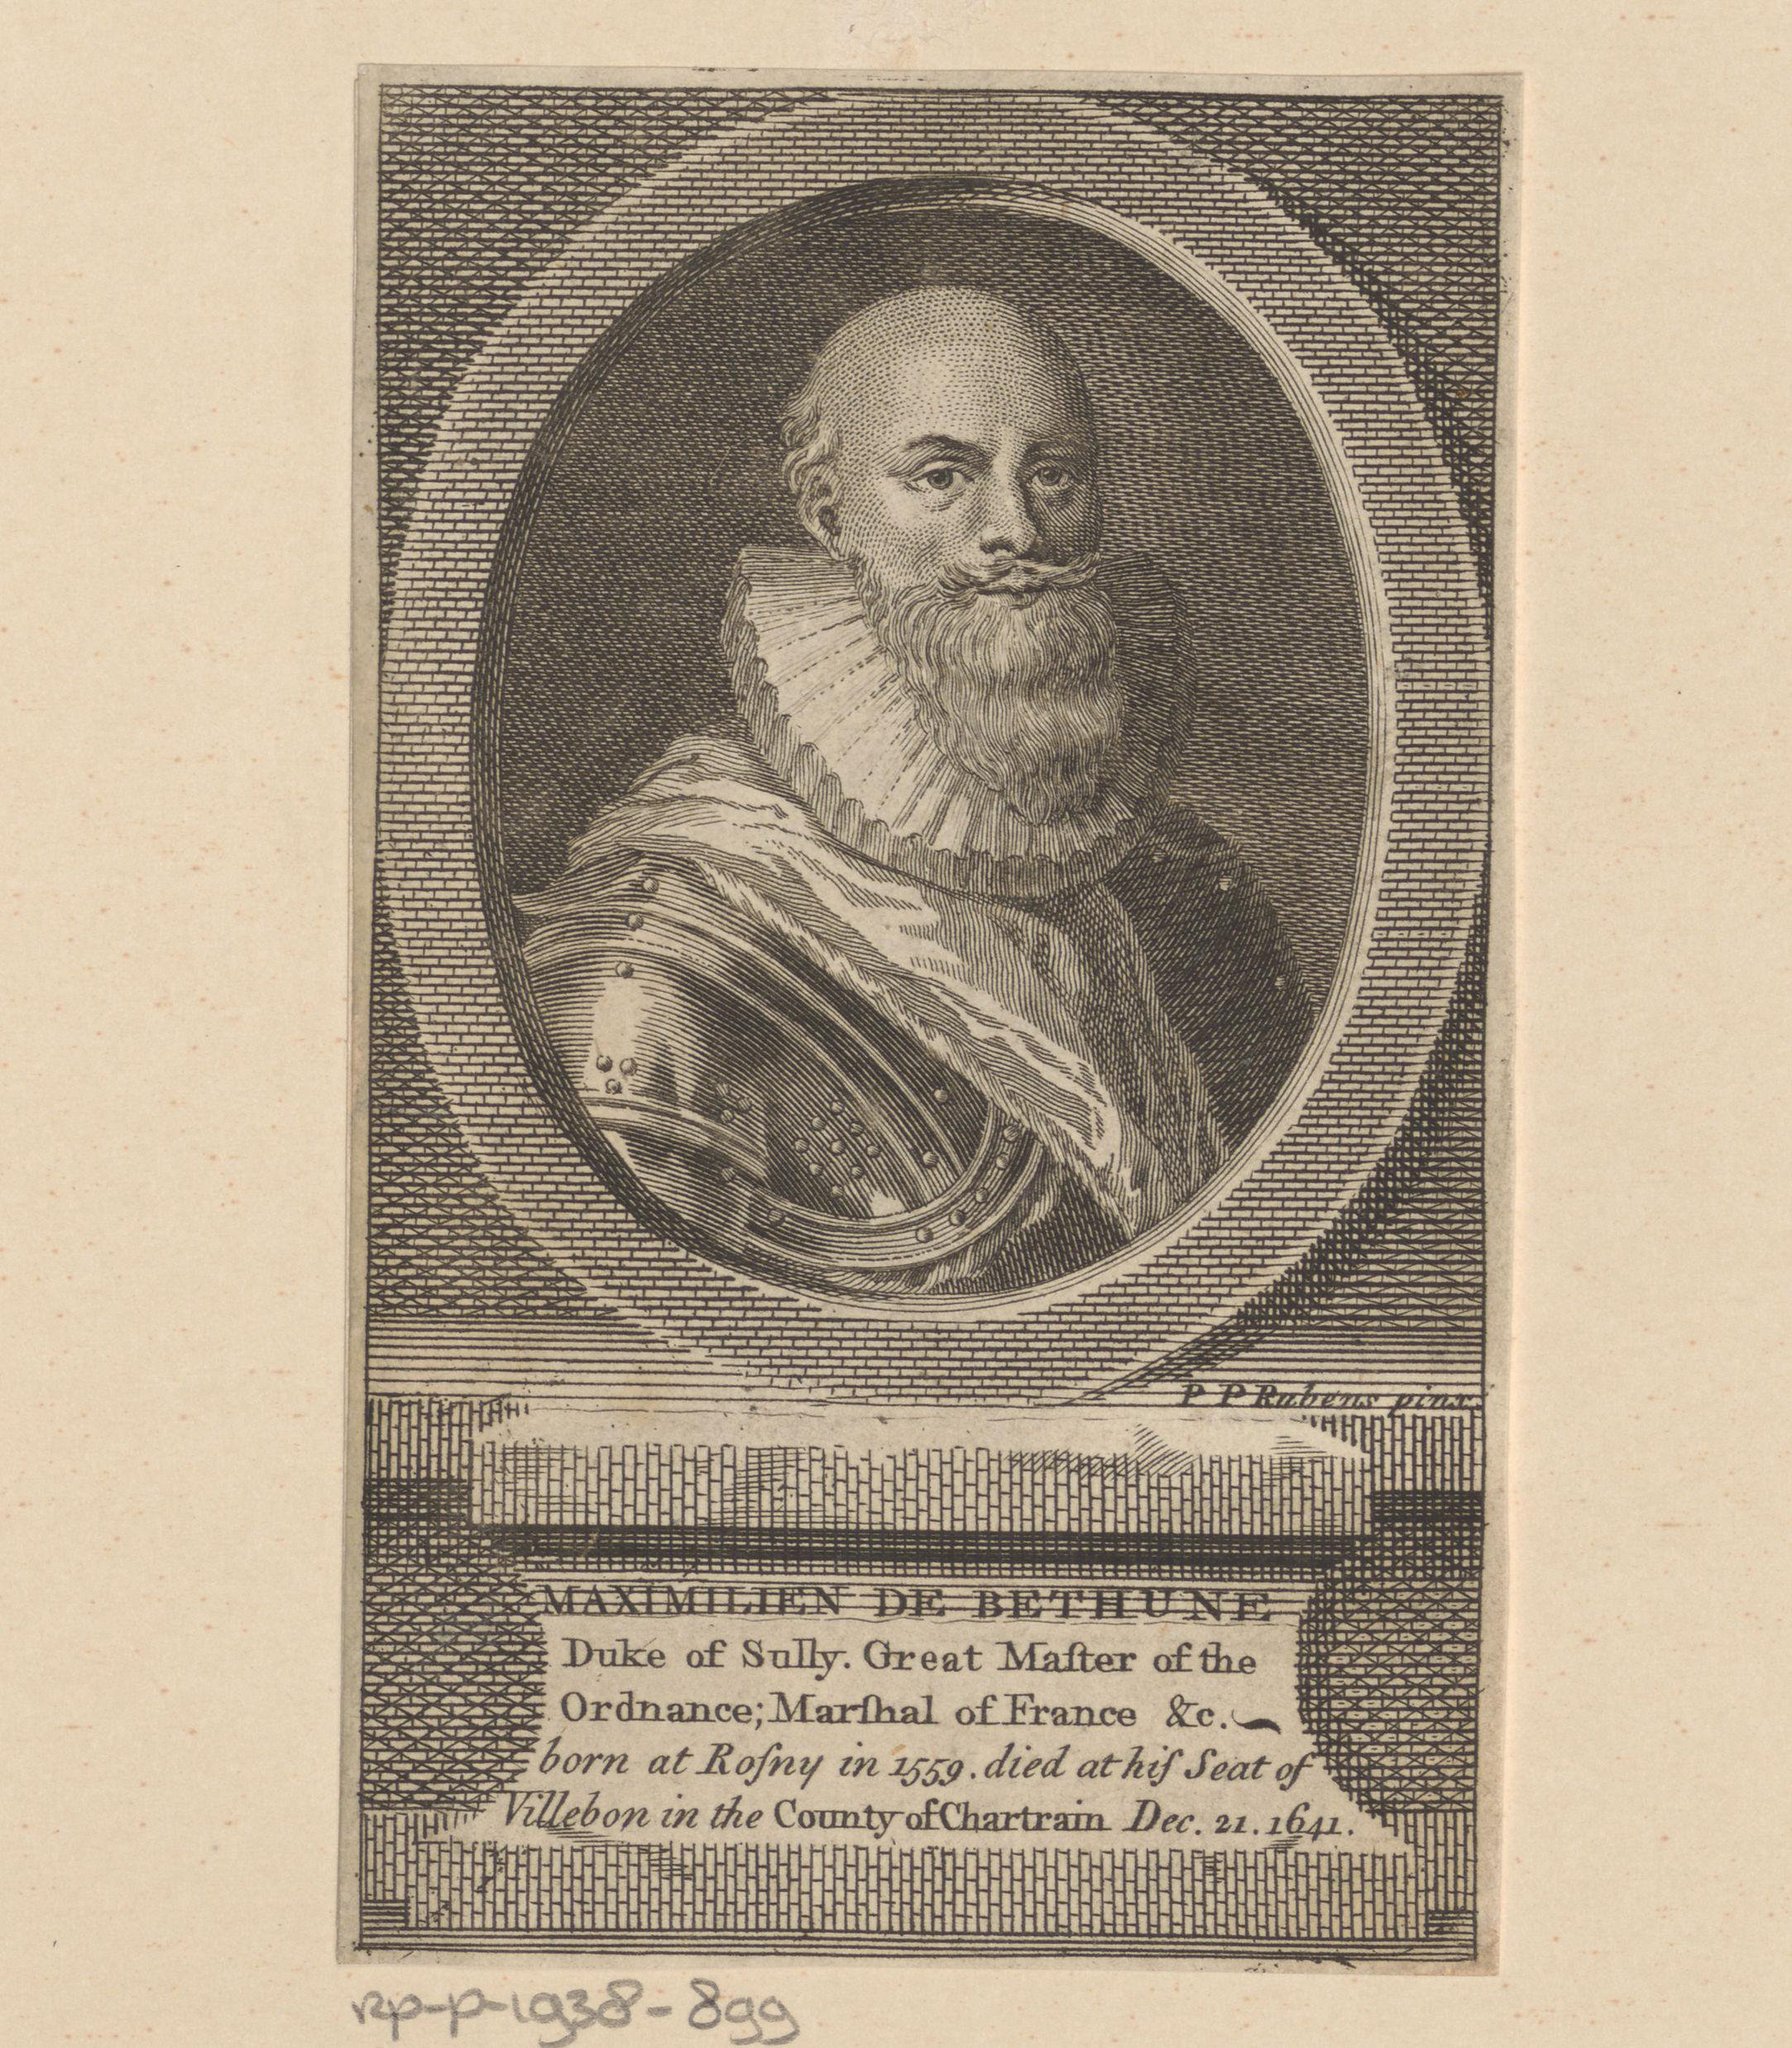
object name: print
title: Portret van Maximilien de Béthune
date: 1700-1800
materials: paper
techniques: etching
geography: england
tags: maximilien de béthune (duke of sully), armour, historical persons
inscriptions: collector's mark: Lugt 2228